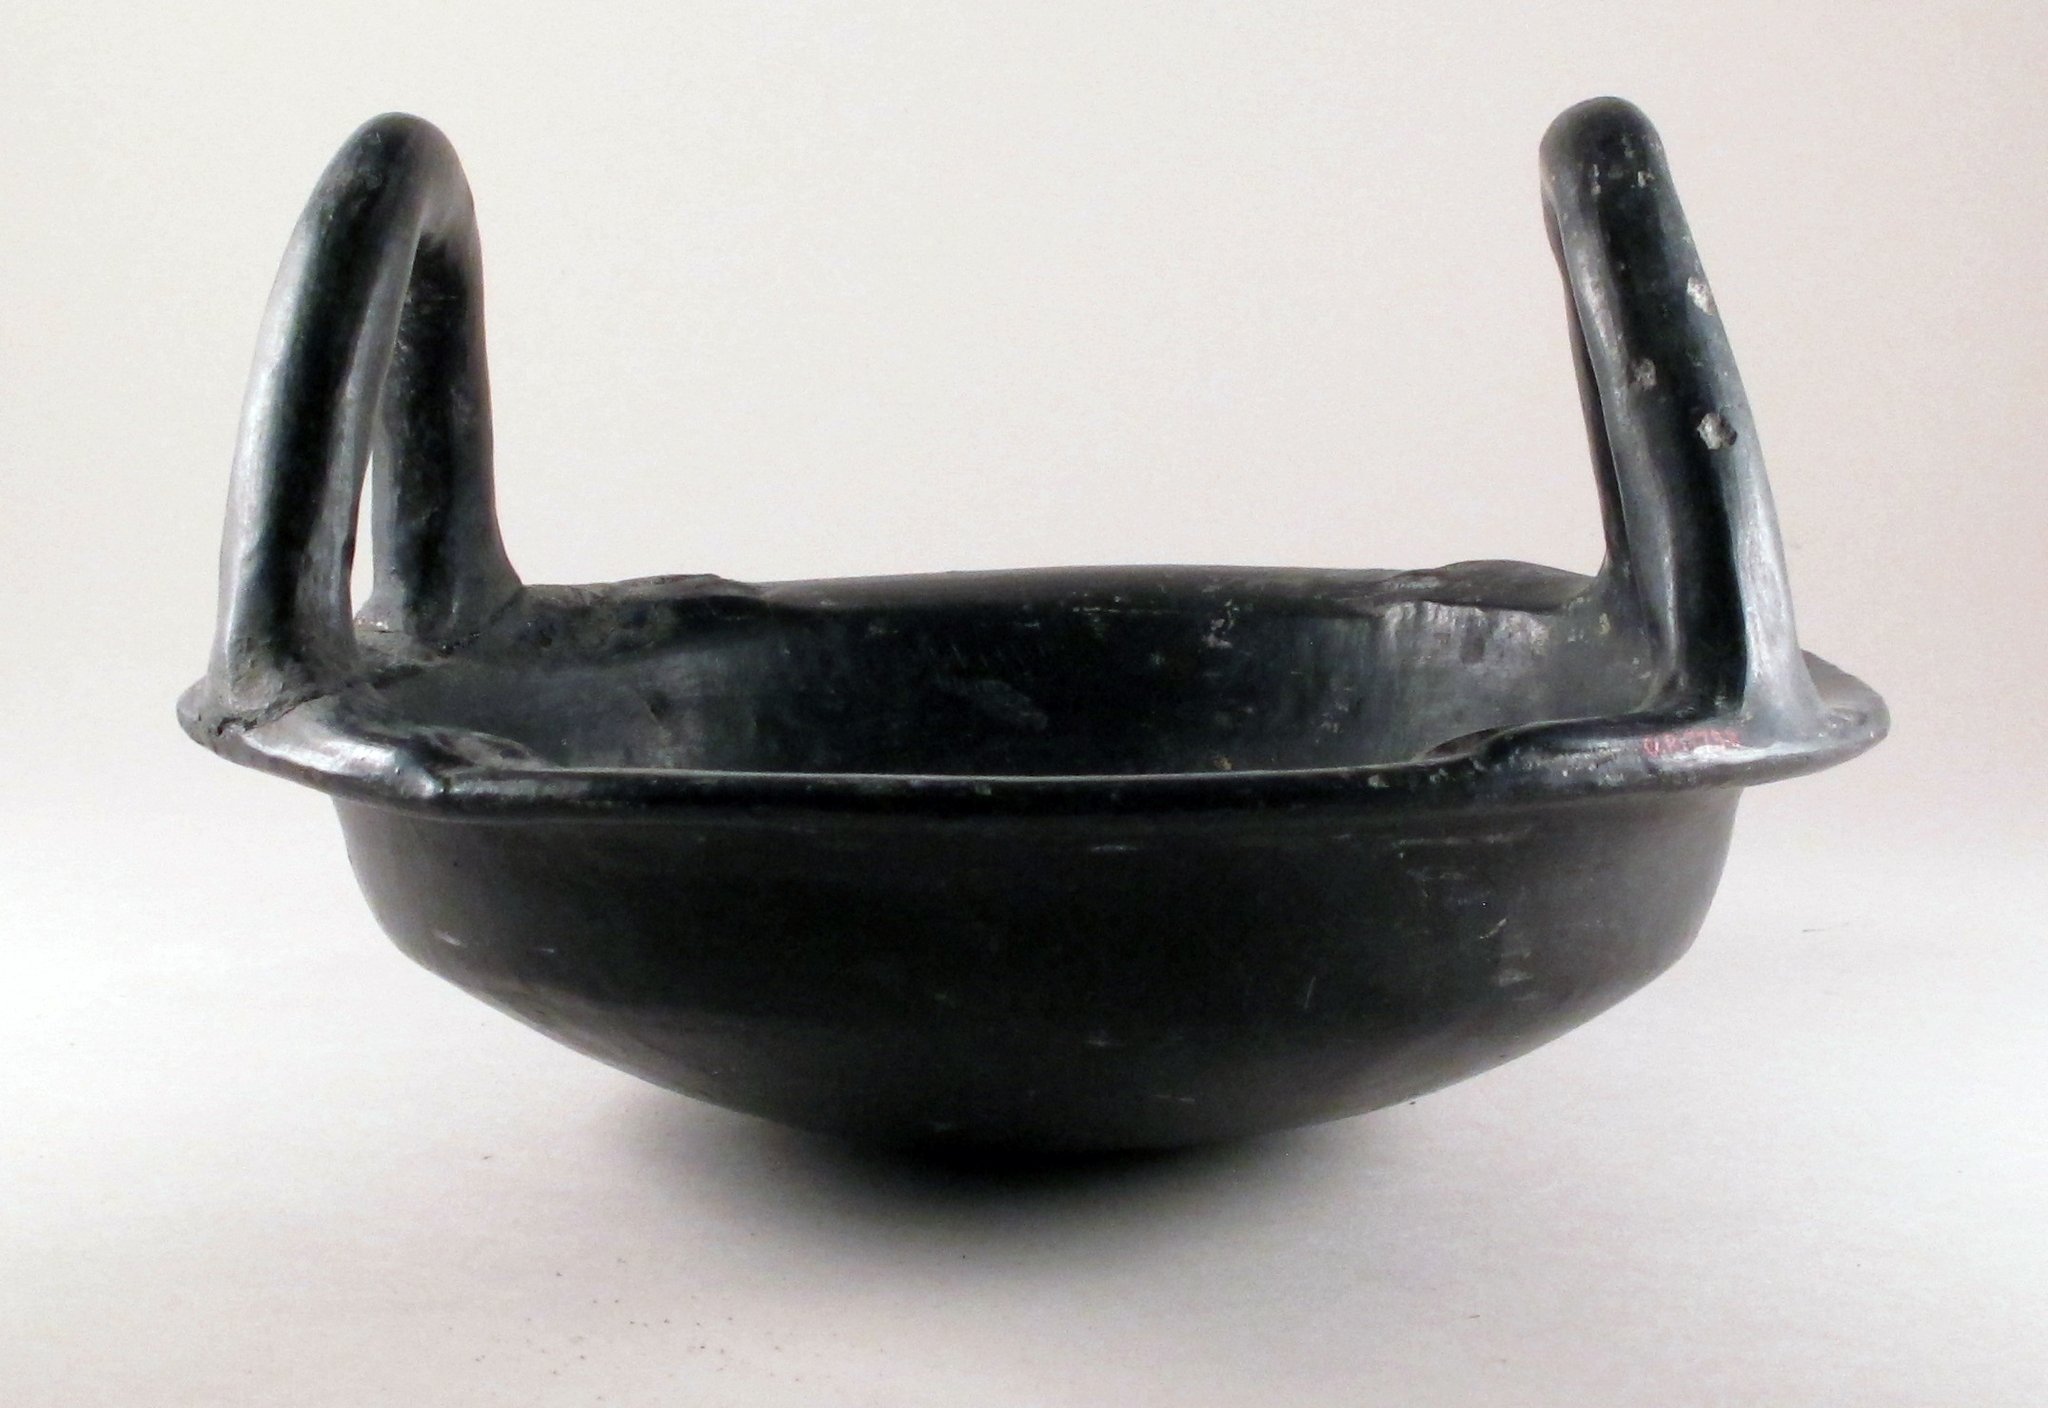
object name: stand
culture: etruscan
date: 550-500 BCE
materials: terracotta